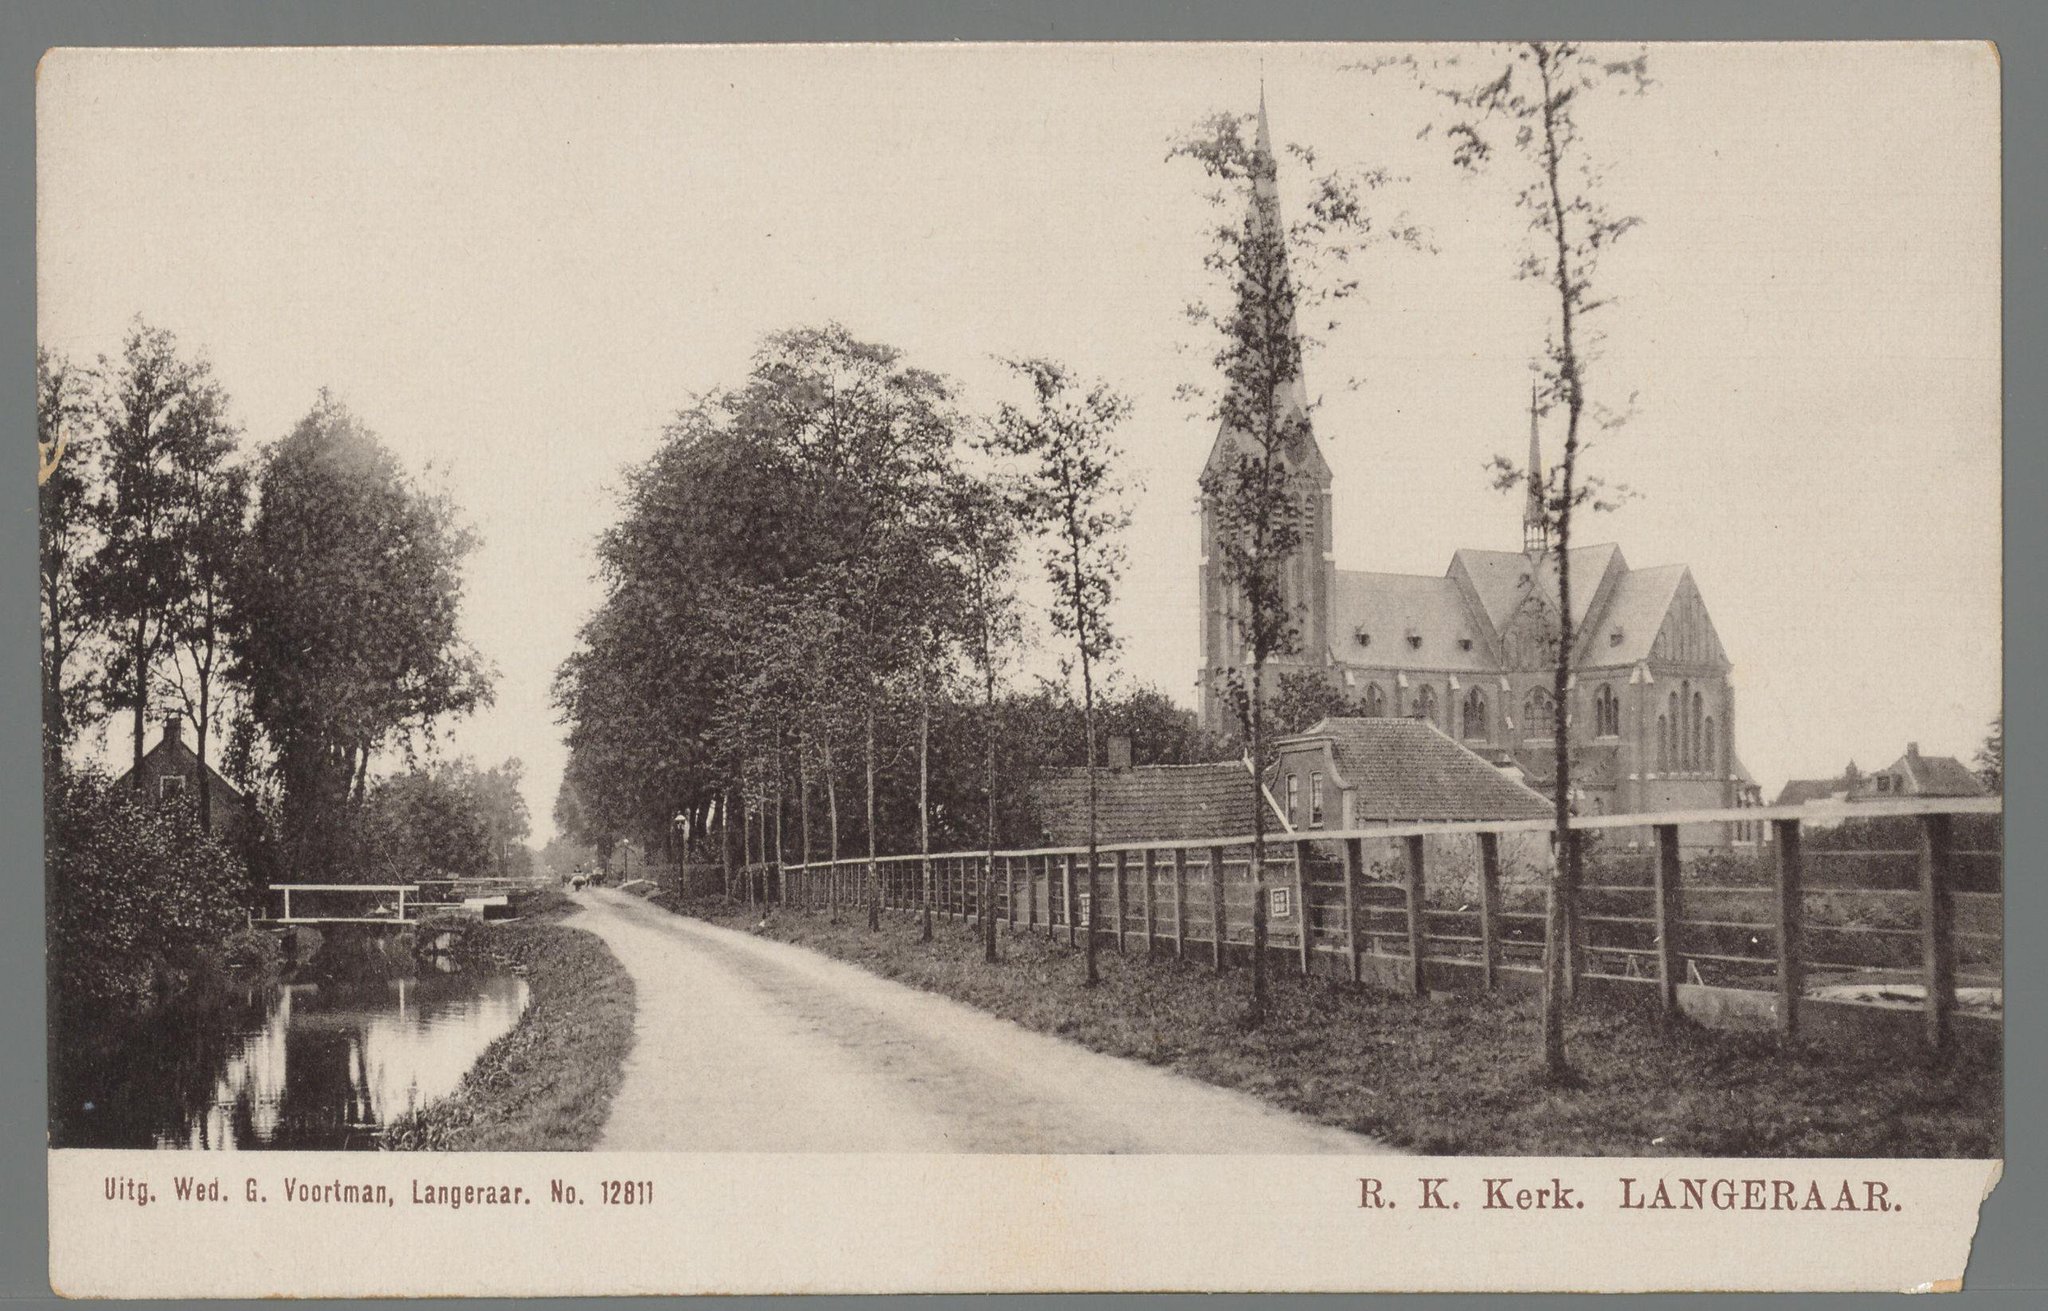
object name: photomechanical print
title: R. K. Kerk. Langeraar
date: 1892-1905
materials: cardboard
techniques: photograph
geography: langeraar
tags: canal, church (exterior), road, path